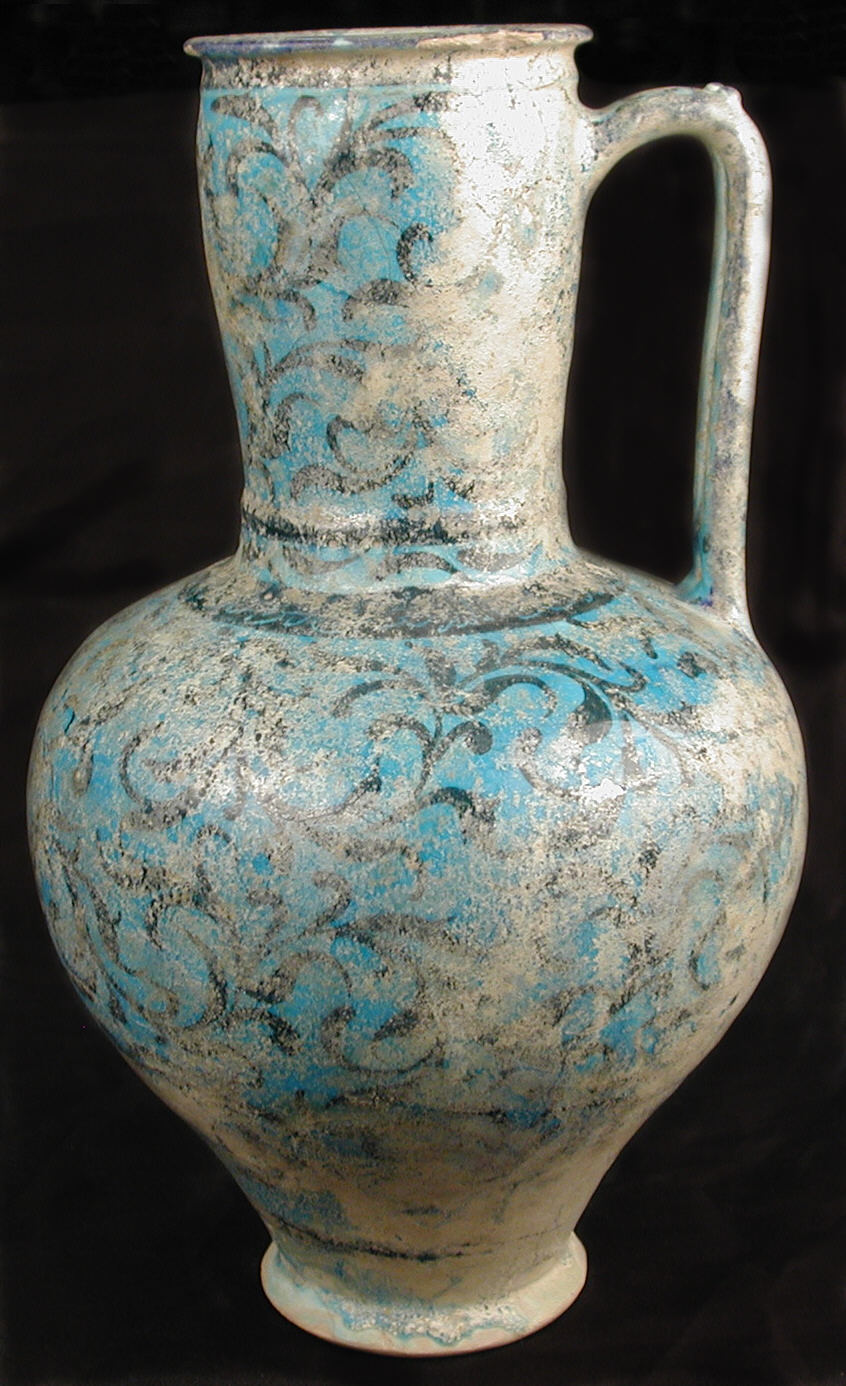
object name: ewer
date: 1201-1233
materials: stonepaste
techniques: glazing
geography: iran